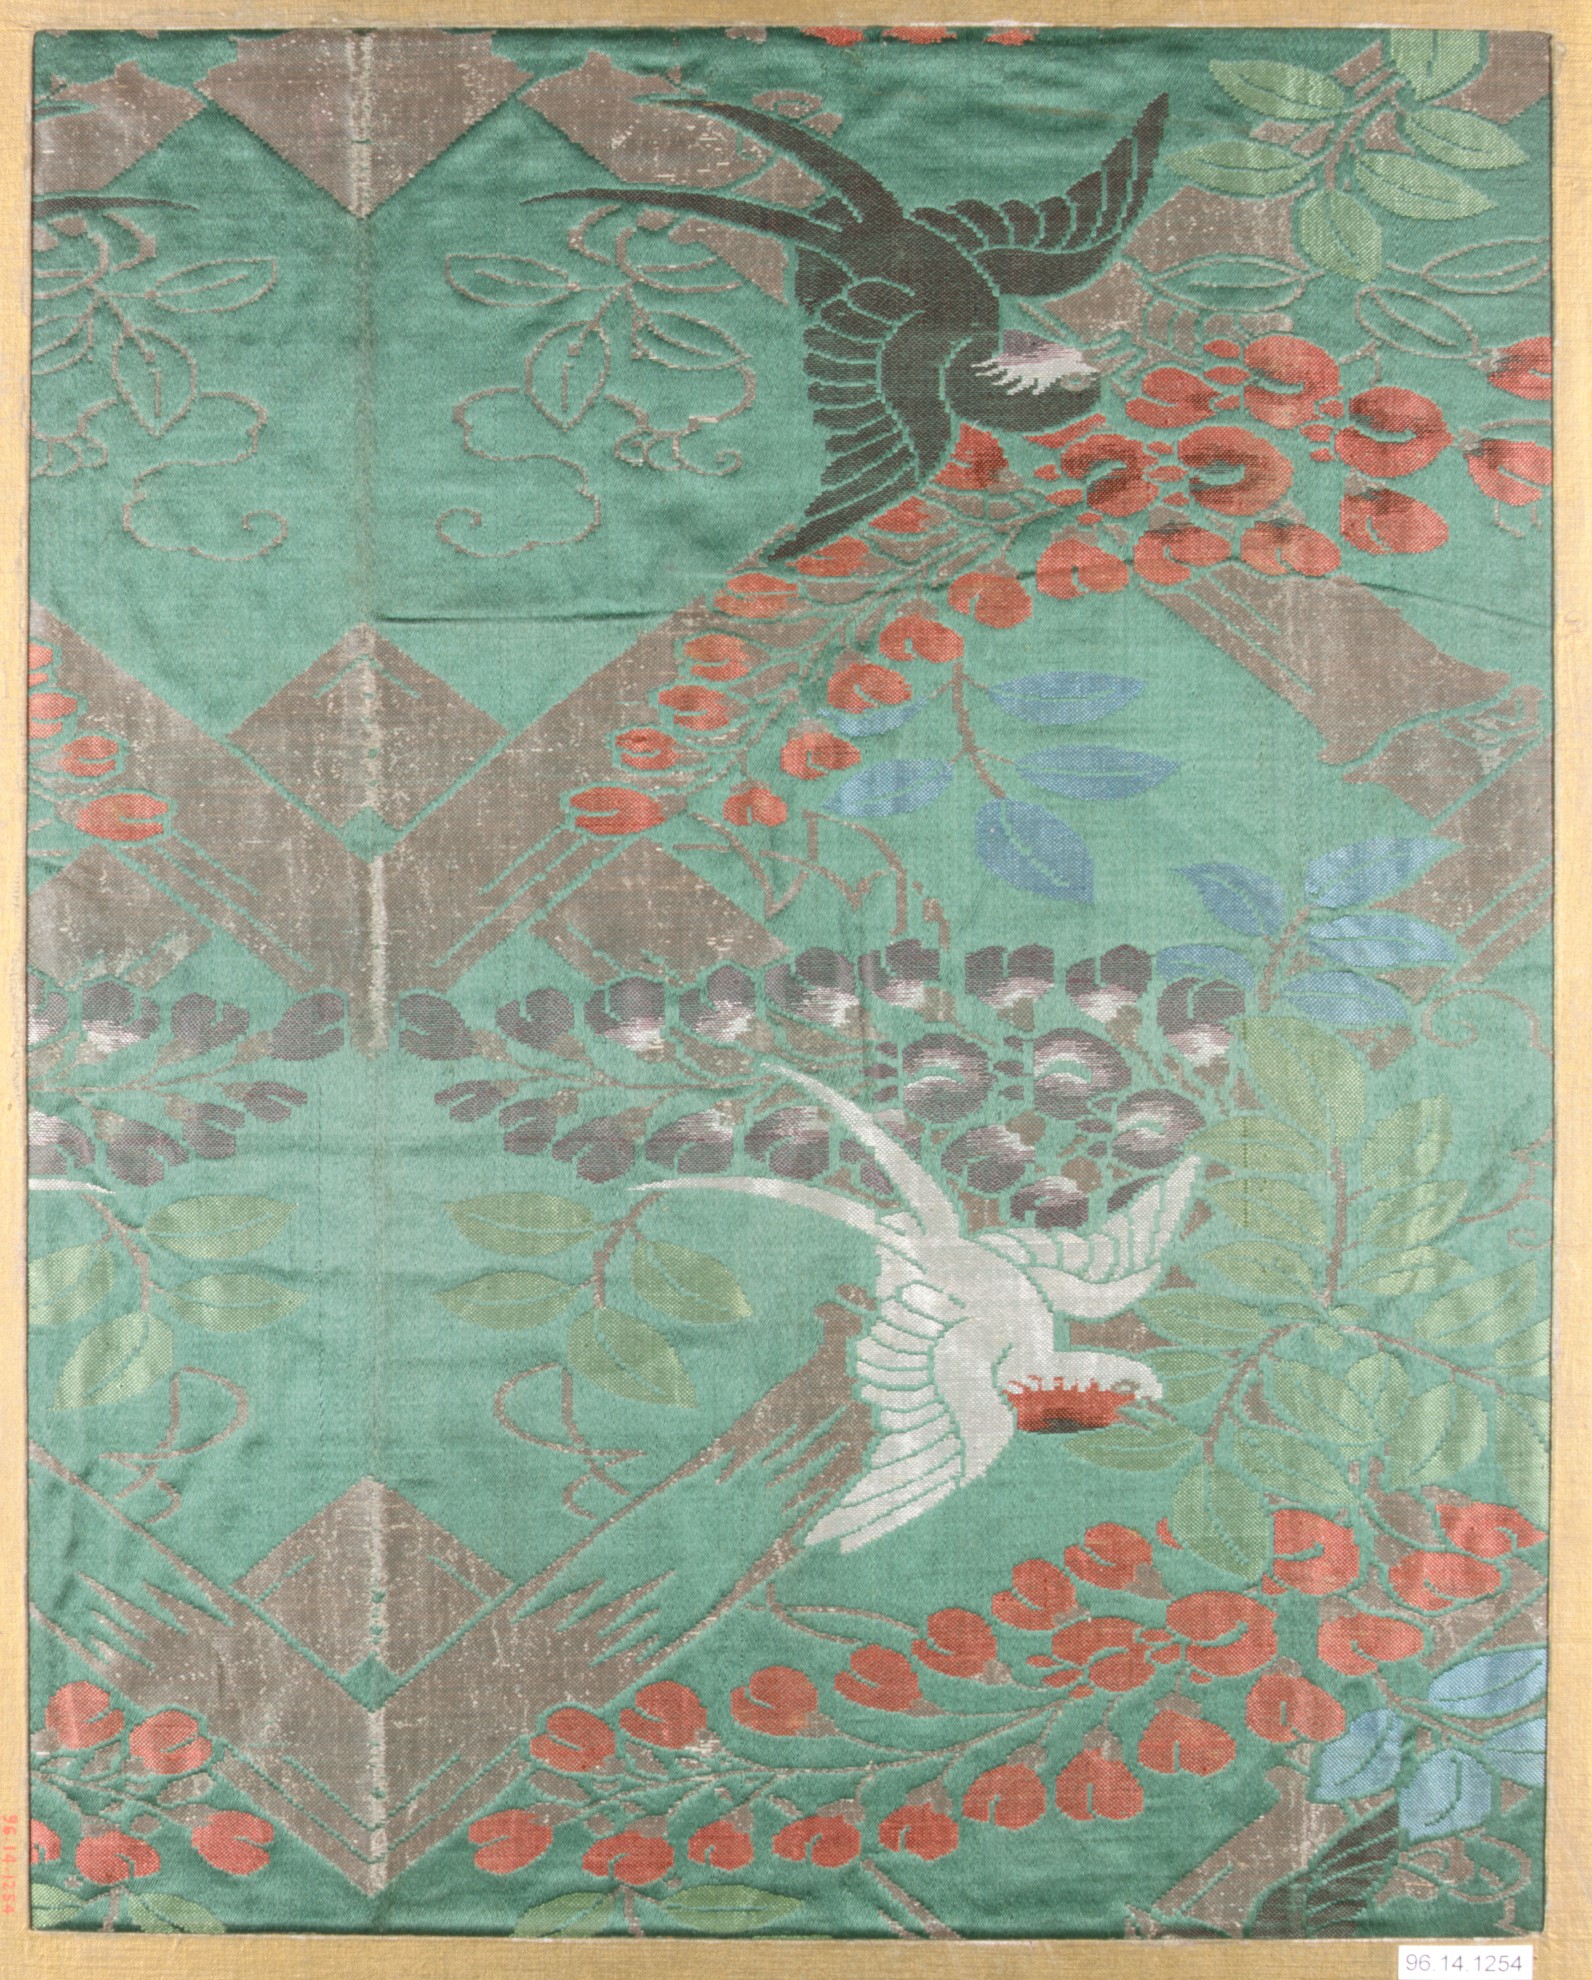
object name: piece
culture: japanese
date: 1701-1900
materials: silk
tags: leaves